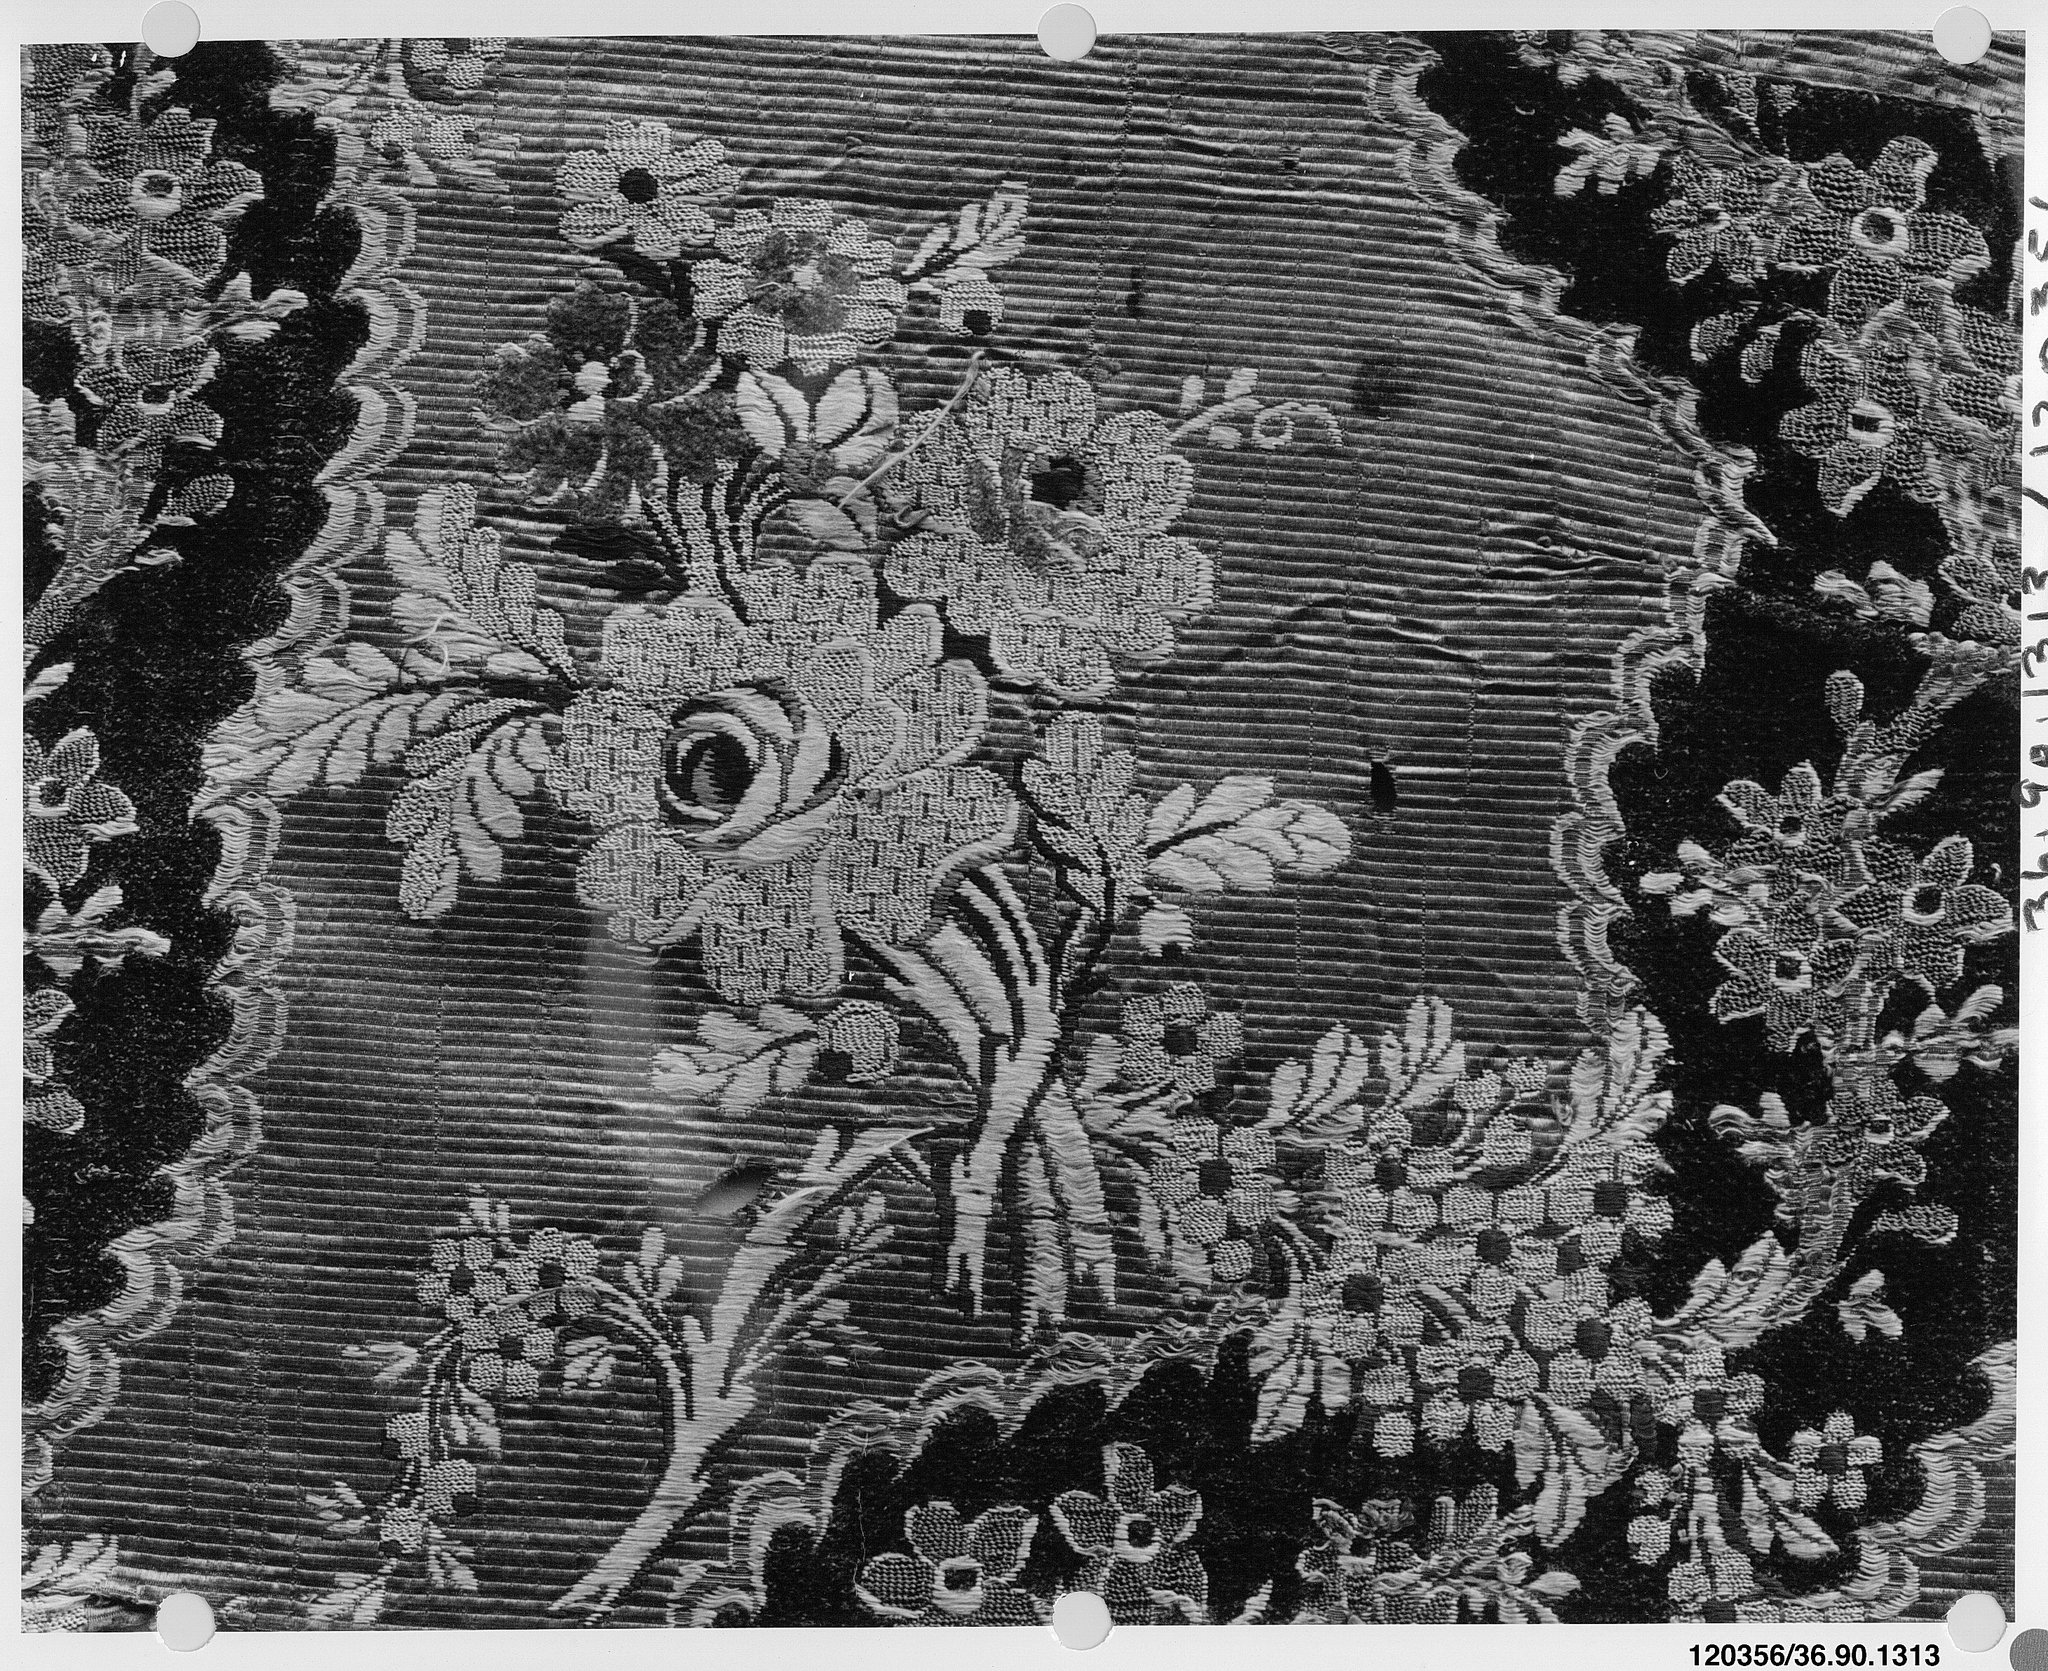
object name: piece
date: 1750-1760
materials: silk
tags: flowers